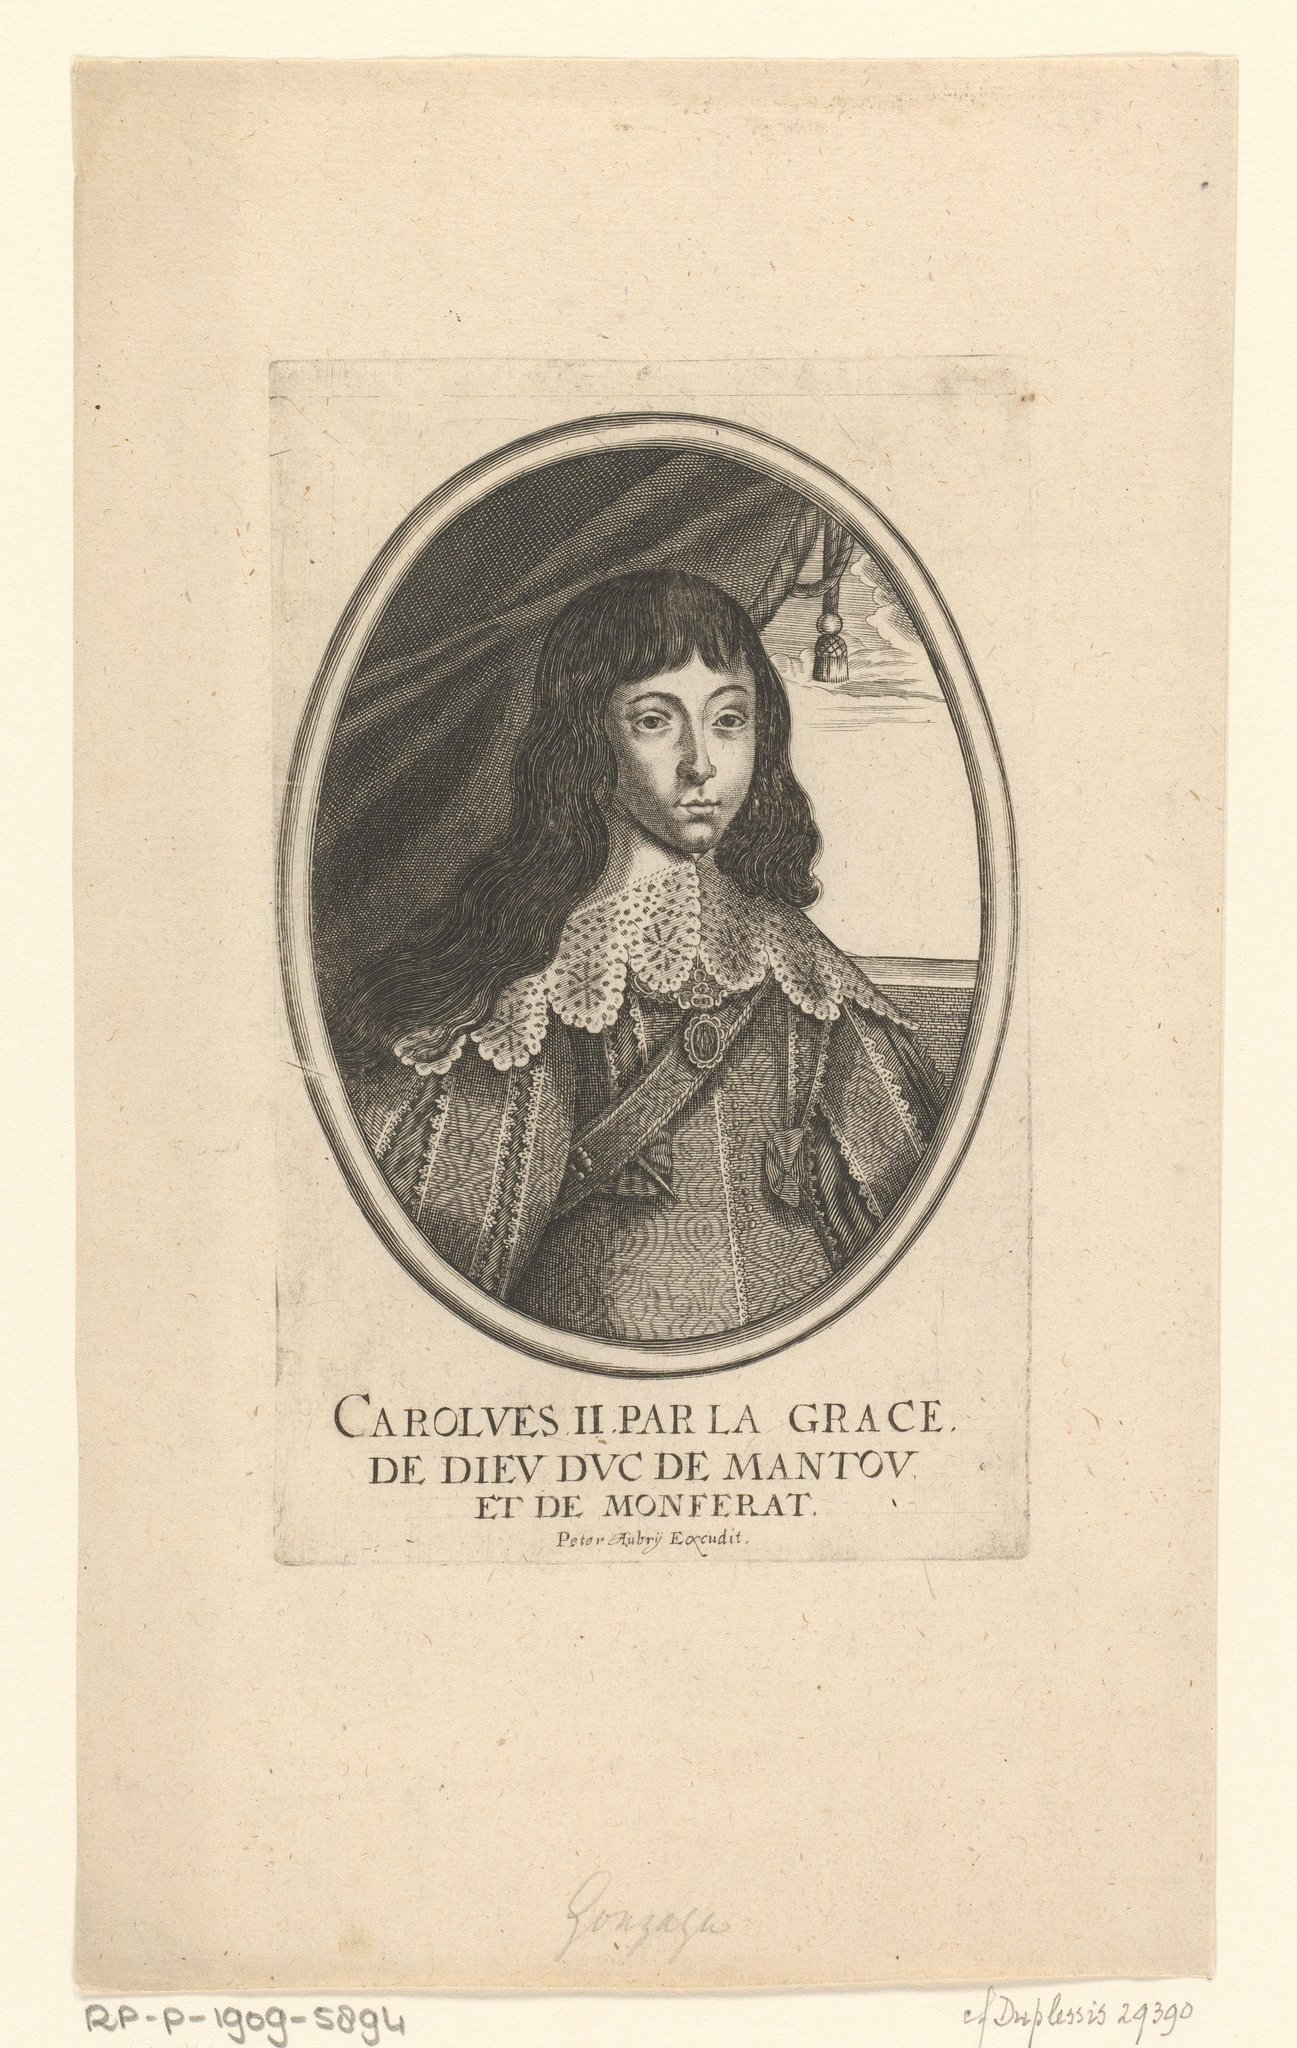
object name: print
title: Portret van Carlo II Gonzaga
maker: Anonymous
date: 1621-1686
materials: paper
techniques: engraving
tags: historical persons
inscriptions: collector's mark: Lugt 2228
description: Met drieregelig onderschrift in het Latijn.